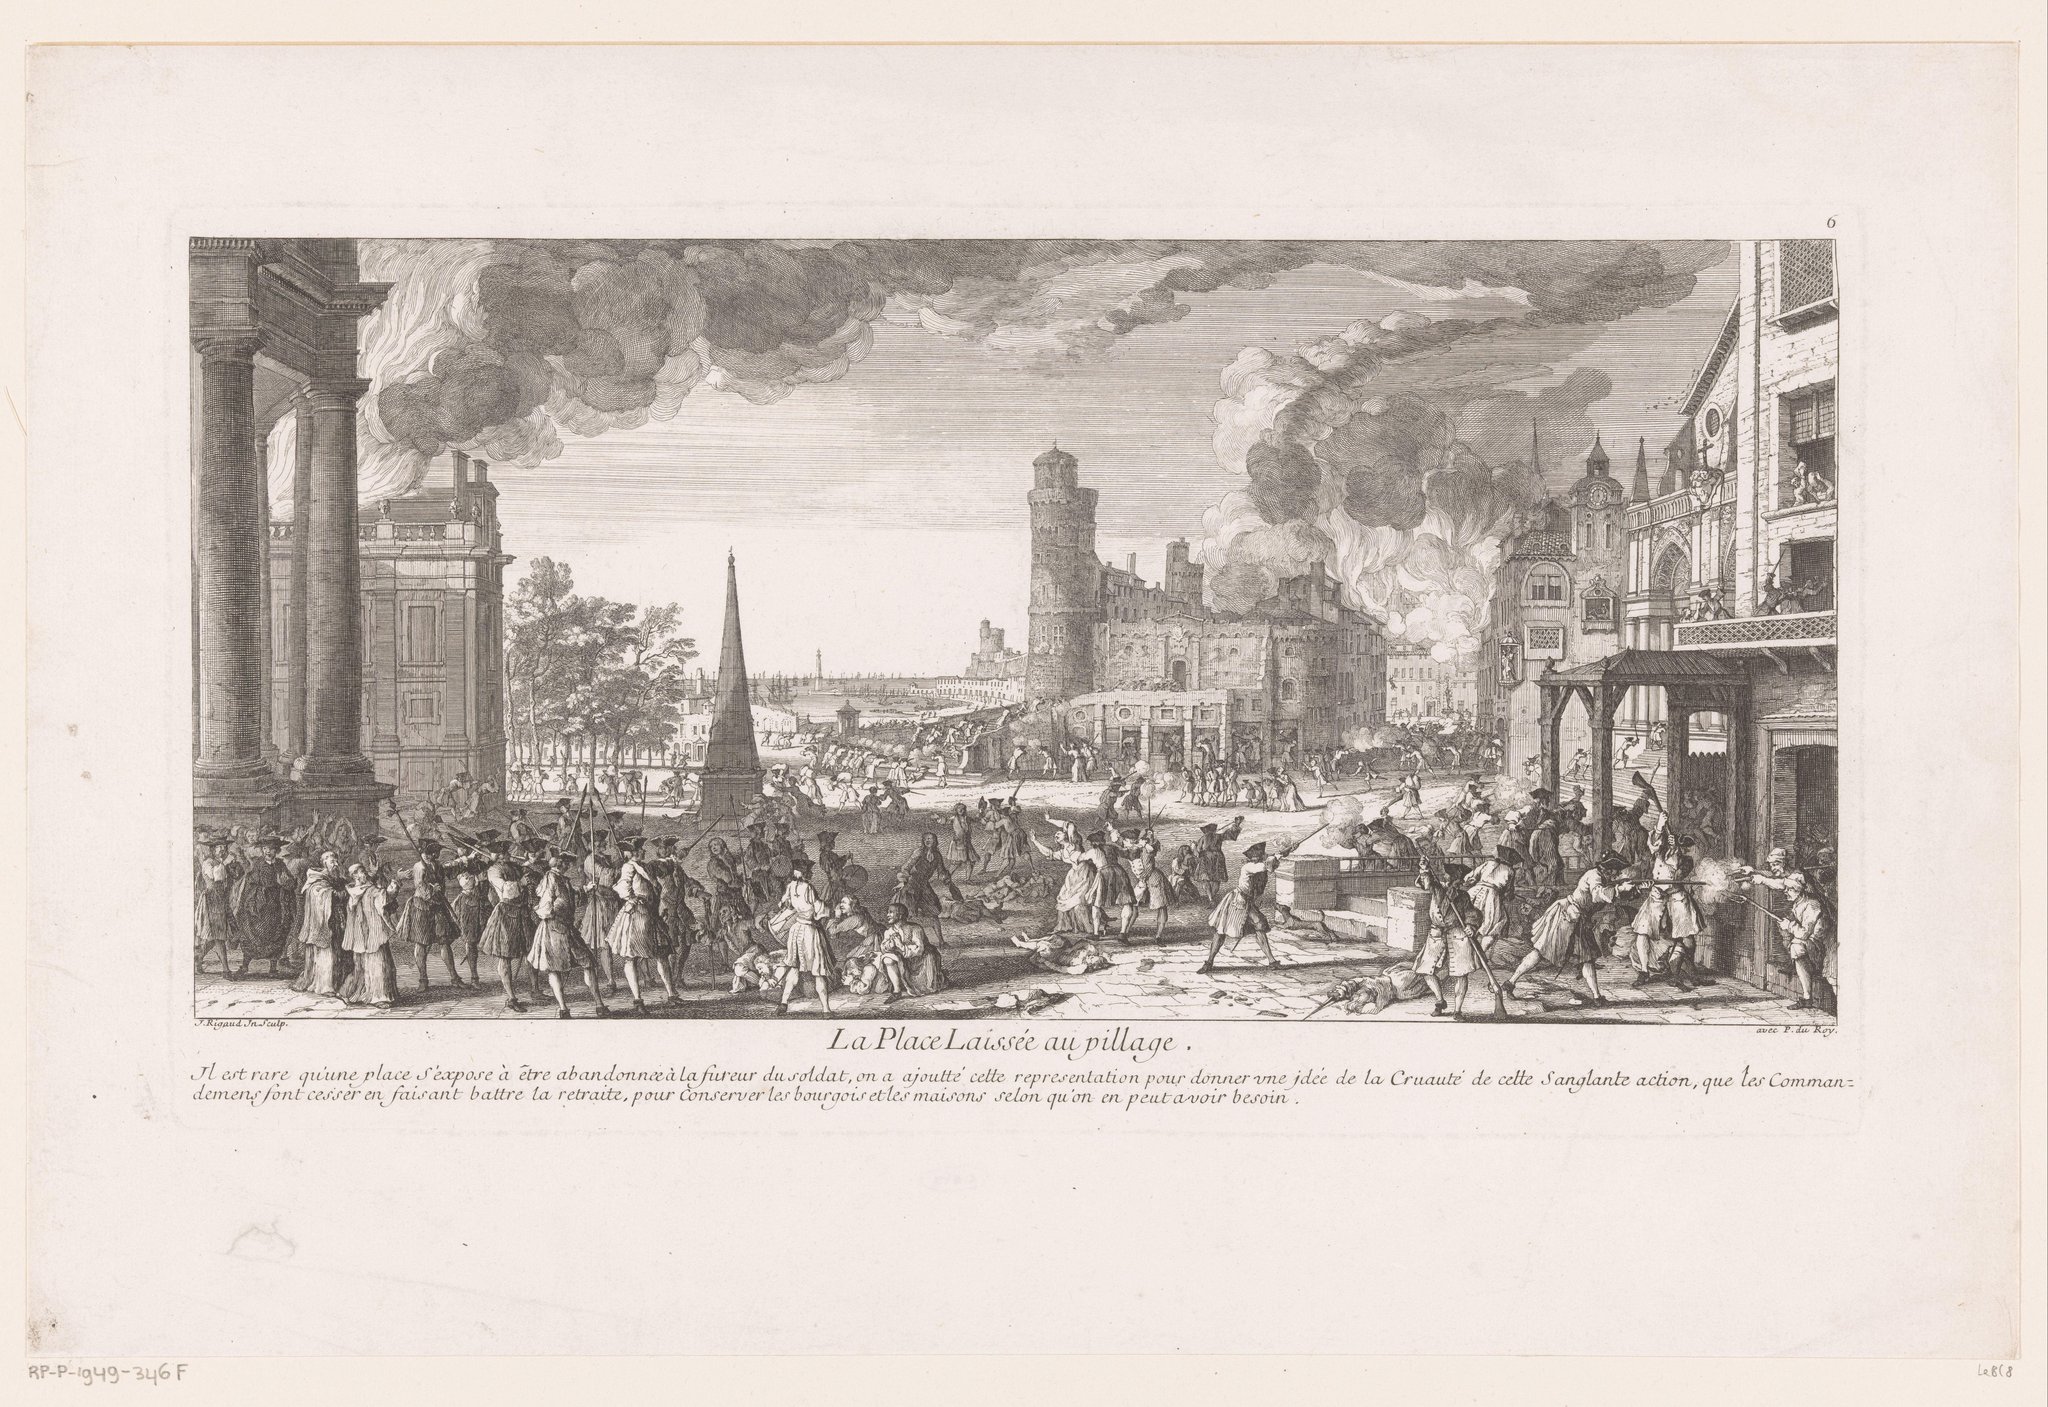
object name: print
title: Belangrijke handelingen bij de belegering van een plaats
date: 1732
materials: paper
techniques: etching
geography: france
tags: plundering ~ soldiers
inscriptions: collector's mark: Lugt 2228